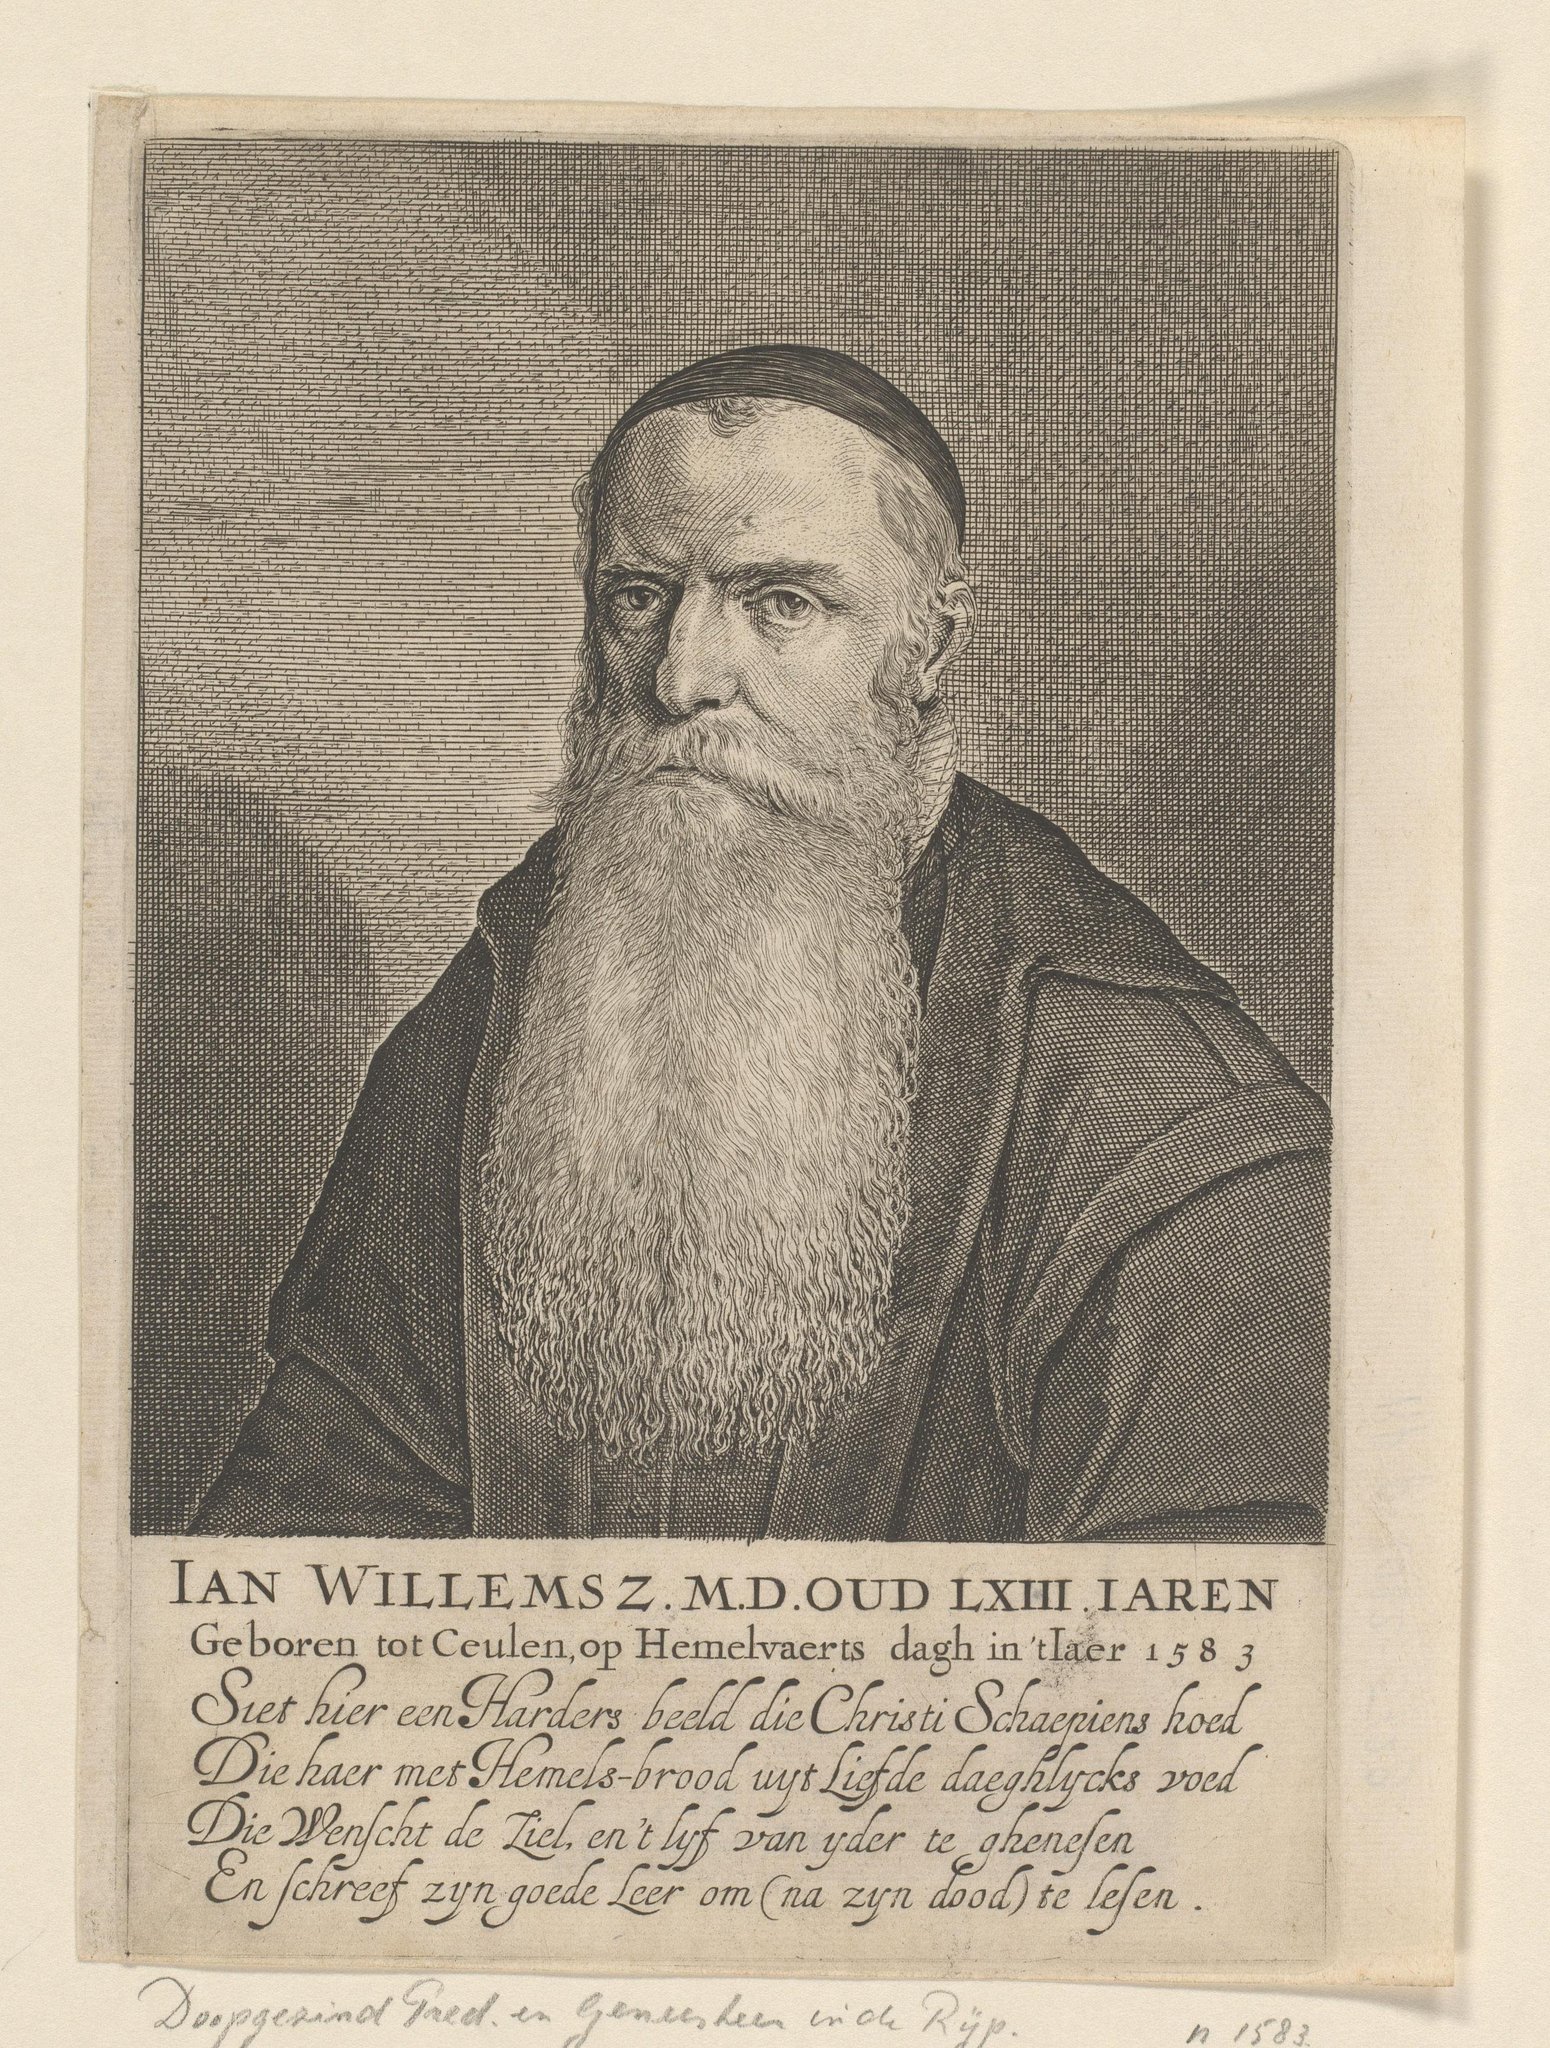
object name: book illustration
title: Portret van Jan Willemsz. op 73-jarige leeftijd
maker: salomon savery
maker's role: print maker, publisher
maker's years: 1594-1683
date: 1647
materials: paper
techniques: engraving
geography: amsterdam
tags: cologne, historical persons, physician, doctor, functionaries and dignitaries ~ protestant churches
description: Prent waarschijnlijk uit: Willemsz., Jan. Postilla, oft sermoenboeck: (...). Hoorn: Isaac Willemsz. vander Beeck, 1647.